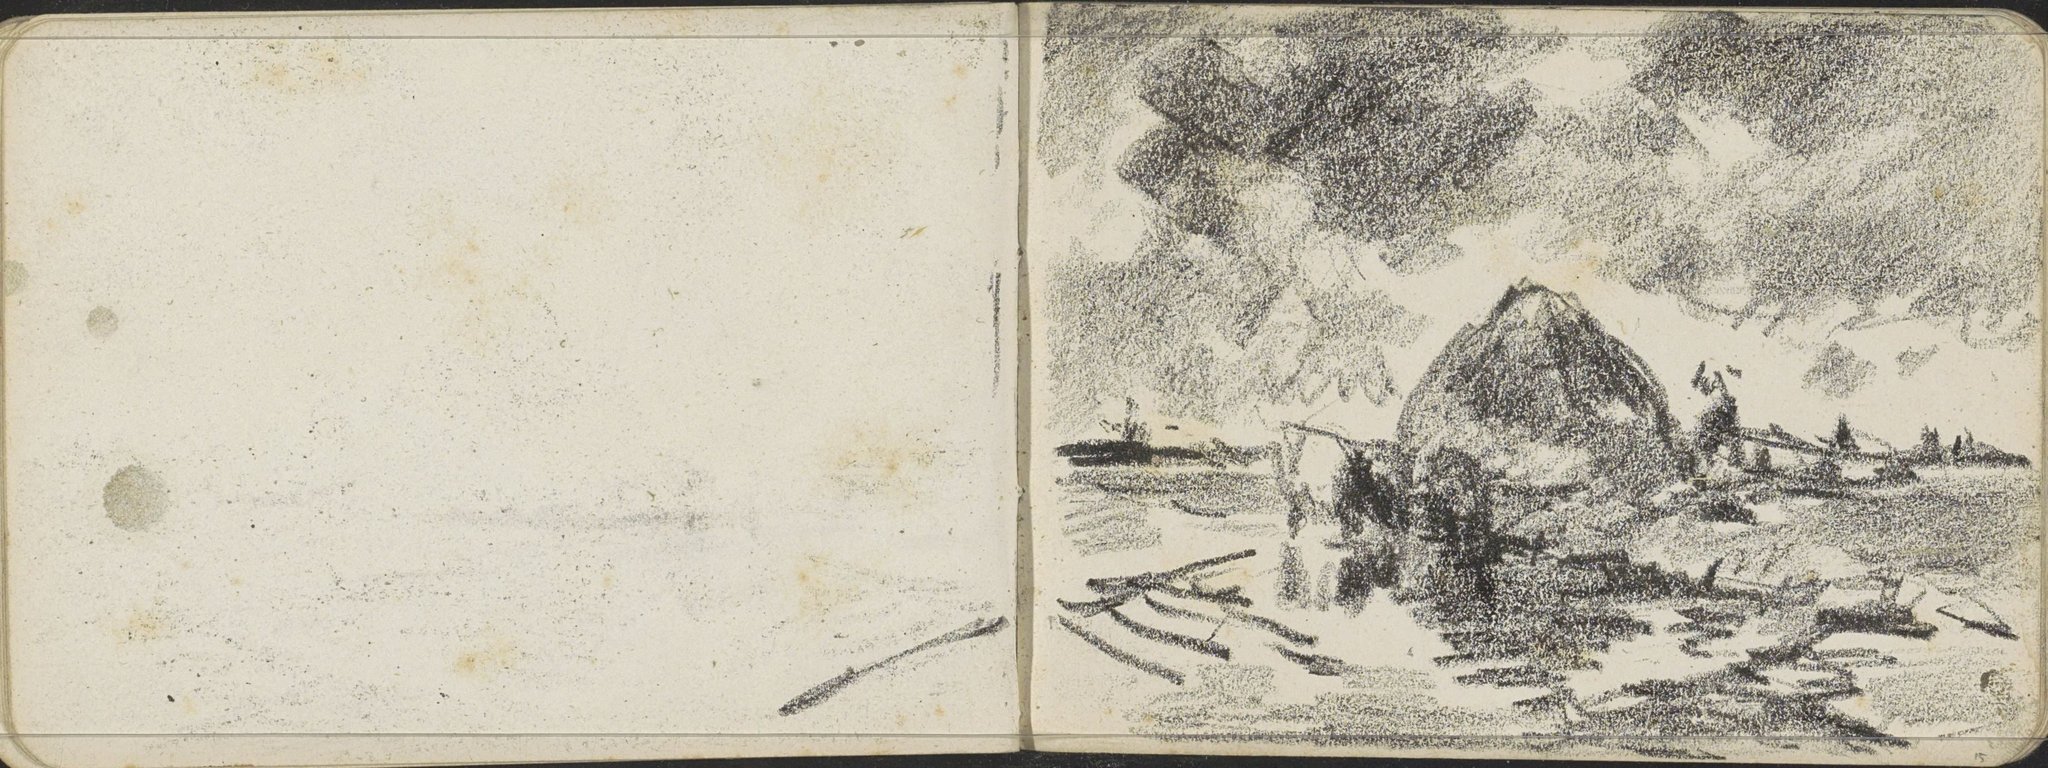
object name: sketchbook leaf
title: Hooiberg in een weiland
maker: willem cornelis rip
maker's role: draughtsman, painter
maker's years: 1856-1922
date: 1907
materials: chalk, paper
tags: hay-stack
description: Blad 14 verso en 15 recto uit een schetsboek met 41 bladen.